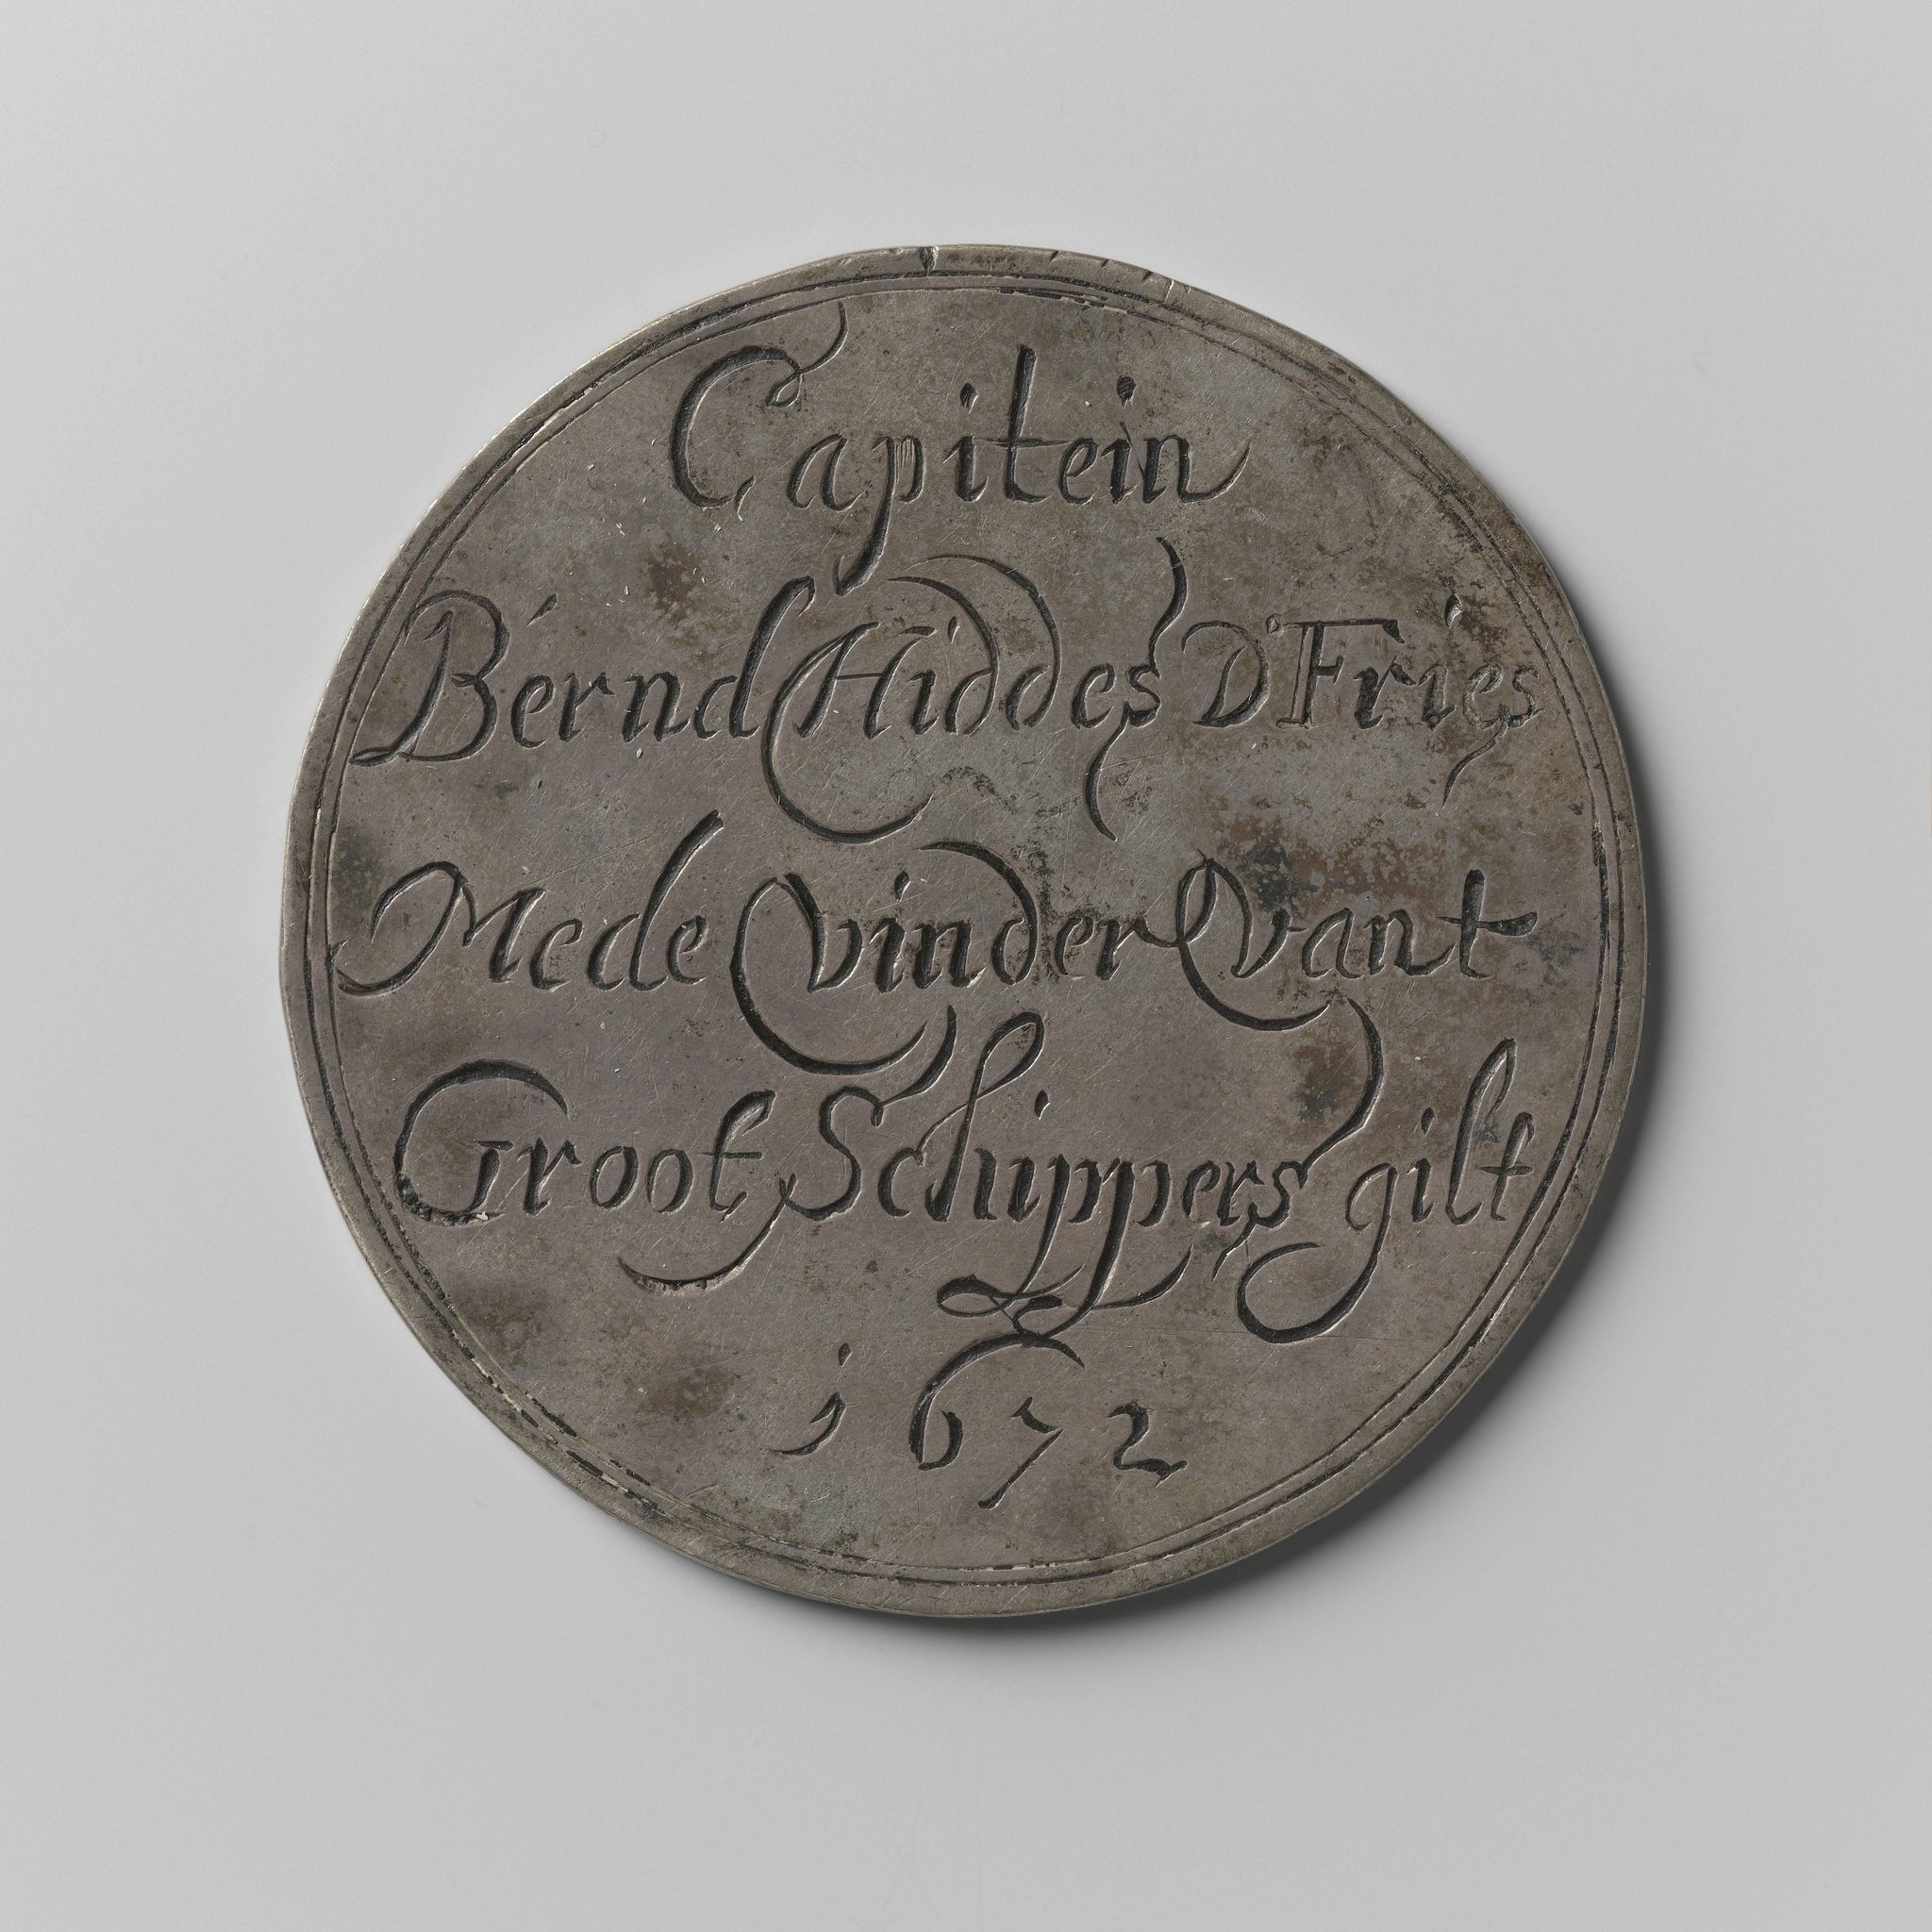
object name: medal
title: Groot schippersgilde van Harlingen, gildepenning van Bernd Hiddes de Fries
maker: Anonymous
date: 1672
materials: silver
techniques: engraving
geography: harlingen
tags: harlingen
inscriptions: inscription: ‘Capitein / Bernd Hiddes D’Fries / Mede vinder vant / Groot Schippers gilt / 1672.’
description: Zilveren penning. Voorzijde: naar rechts varende driemaster. Keerzijde: opschrift.